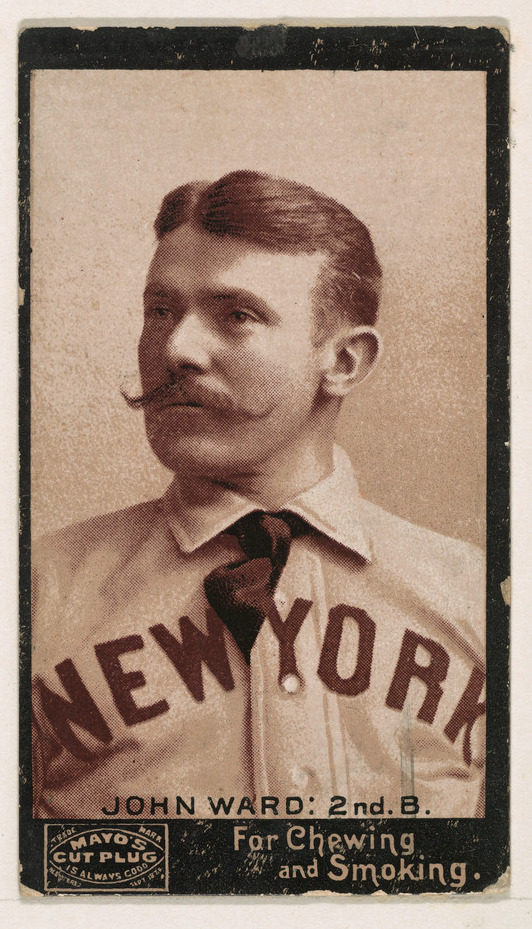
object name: print, baseball card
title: John Ward, 2nd Base, New York, from Mayo's Cut Plug Baseball series (N300)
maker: p.h. mayo & brother, richmond, virginia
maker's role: publisher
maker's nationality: american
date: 1895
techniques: lithography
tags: men,portraits,baseball,athletes